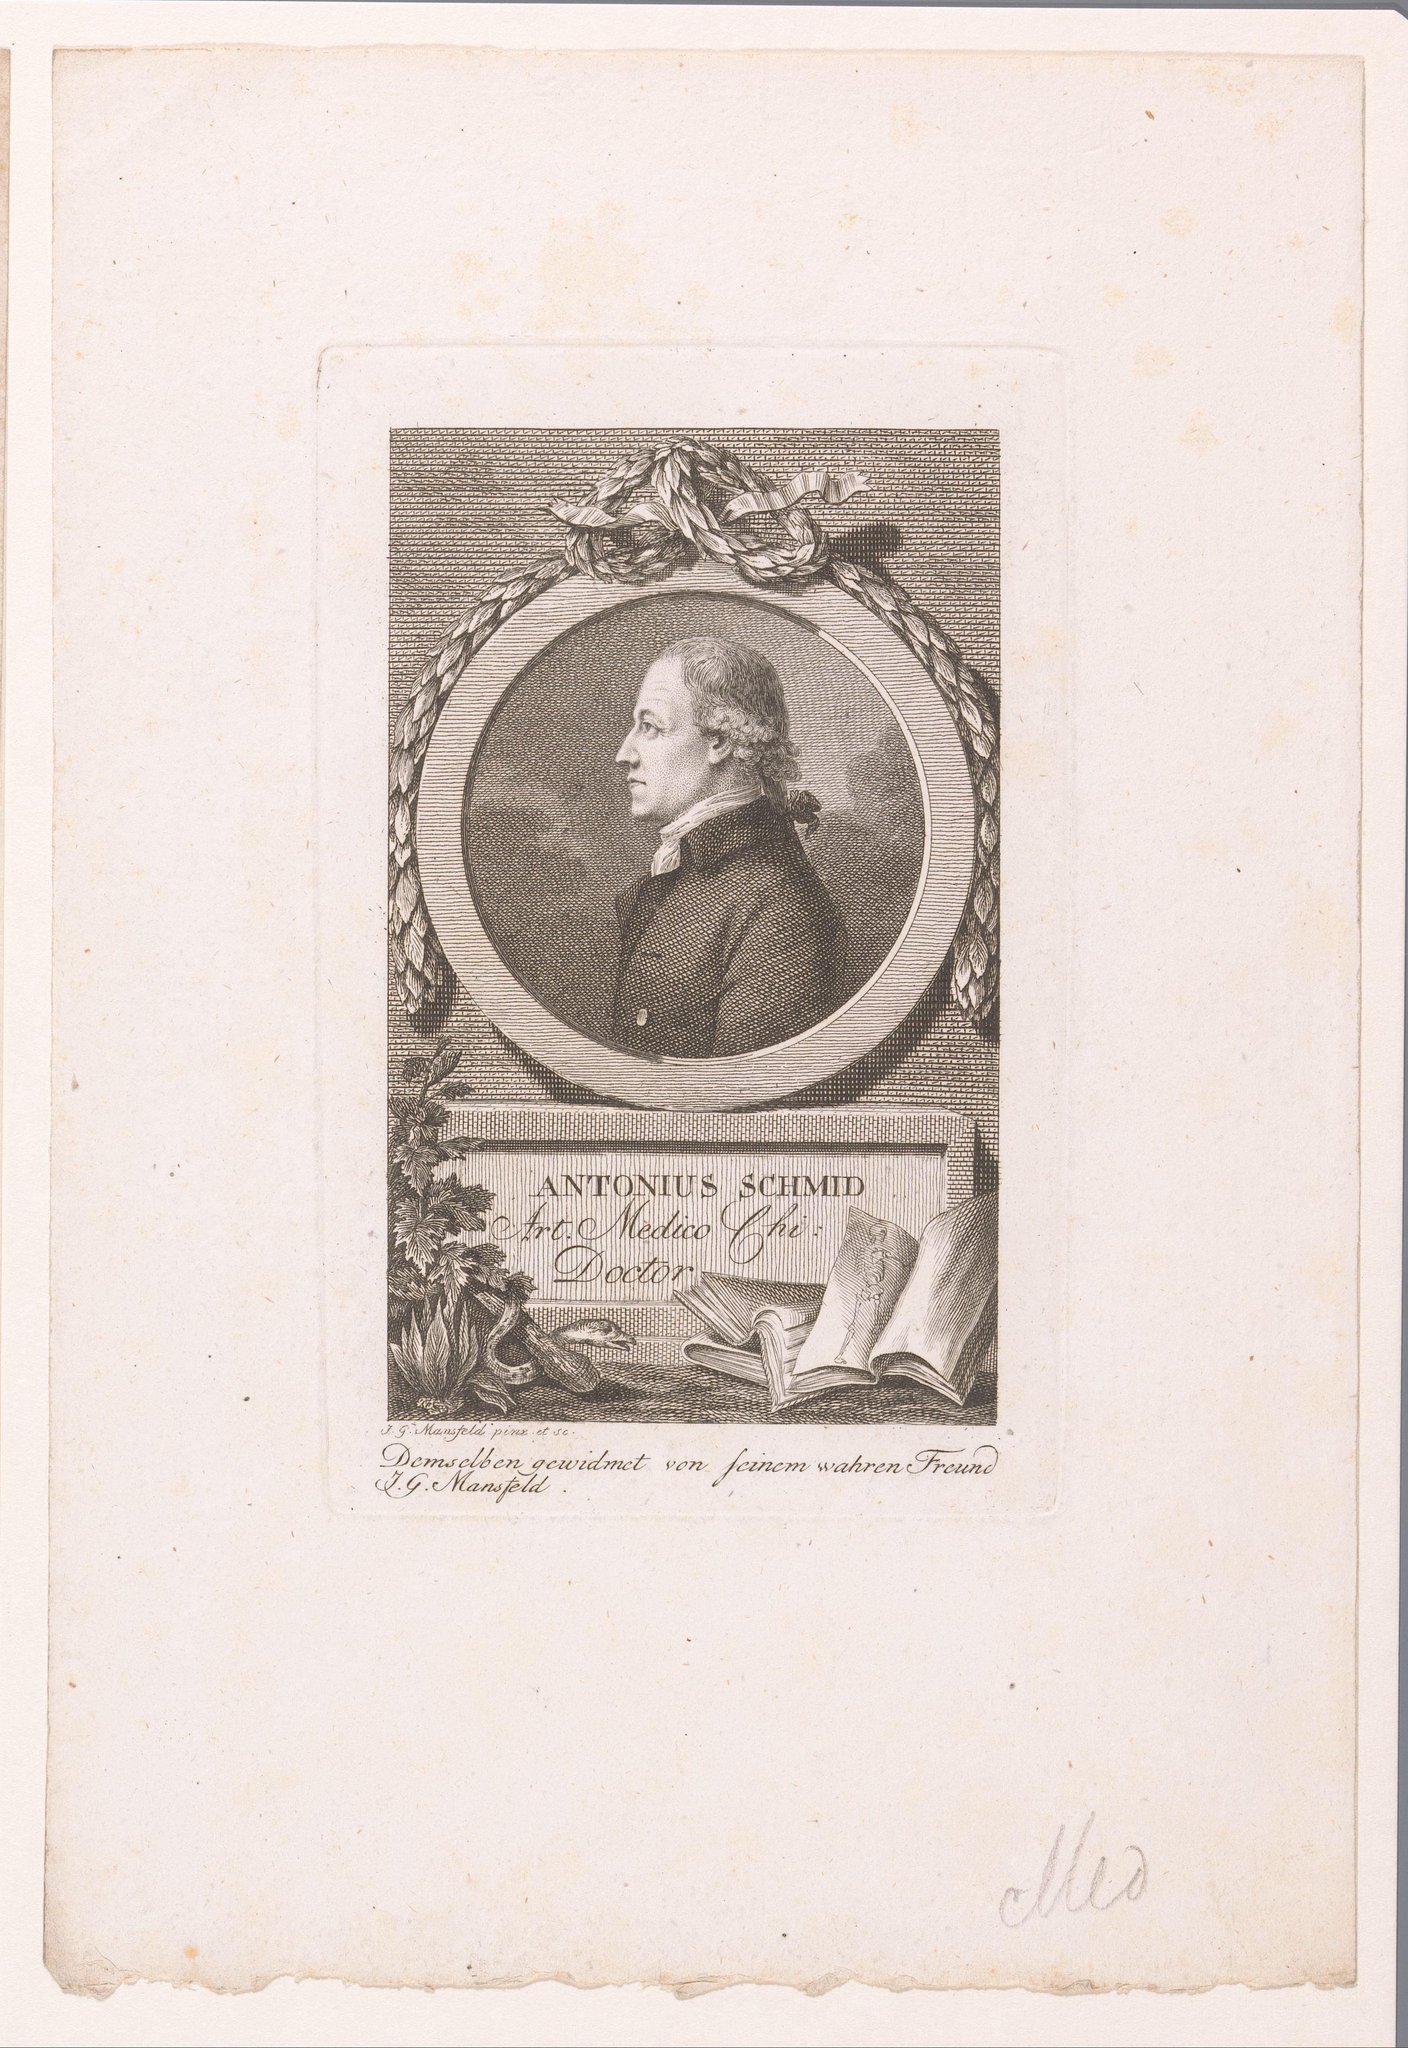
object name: print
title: Portret van Antonius Schmid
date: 1774-1817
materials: paper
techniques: engraving, etching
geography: vienna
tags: antonius schmid, historical persons, book - mm - book open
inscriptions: collector's mark: Lugt 2228